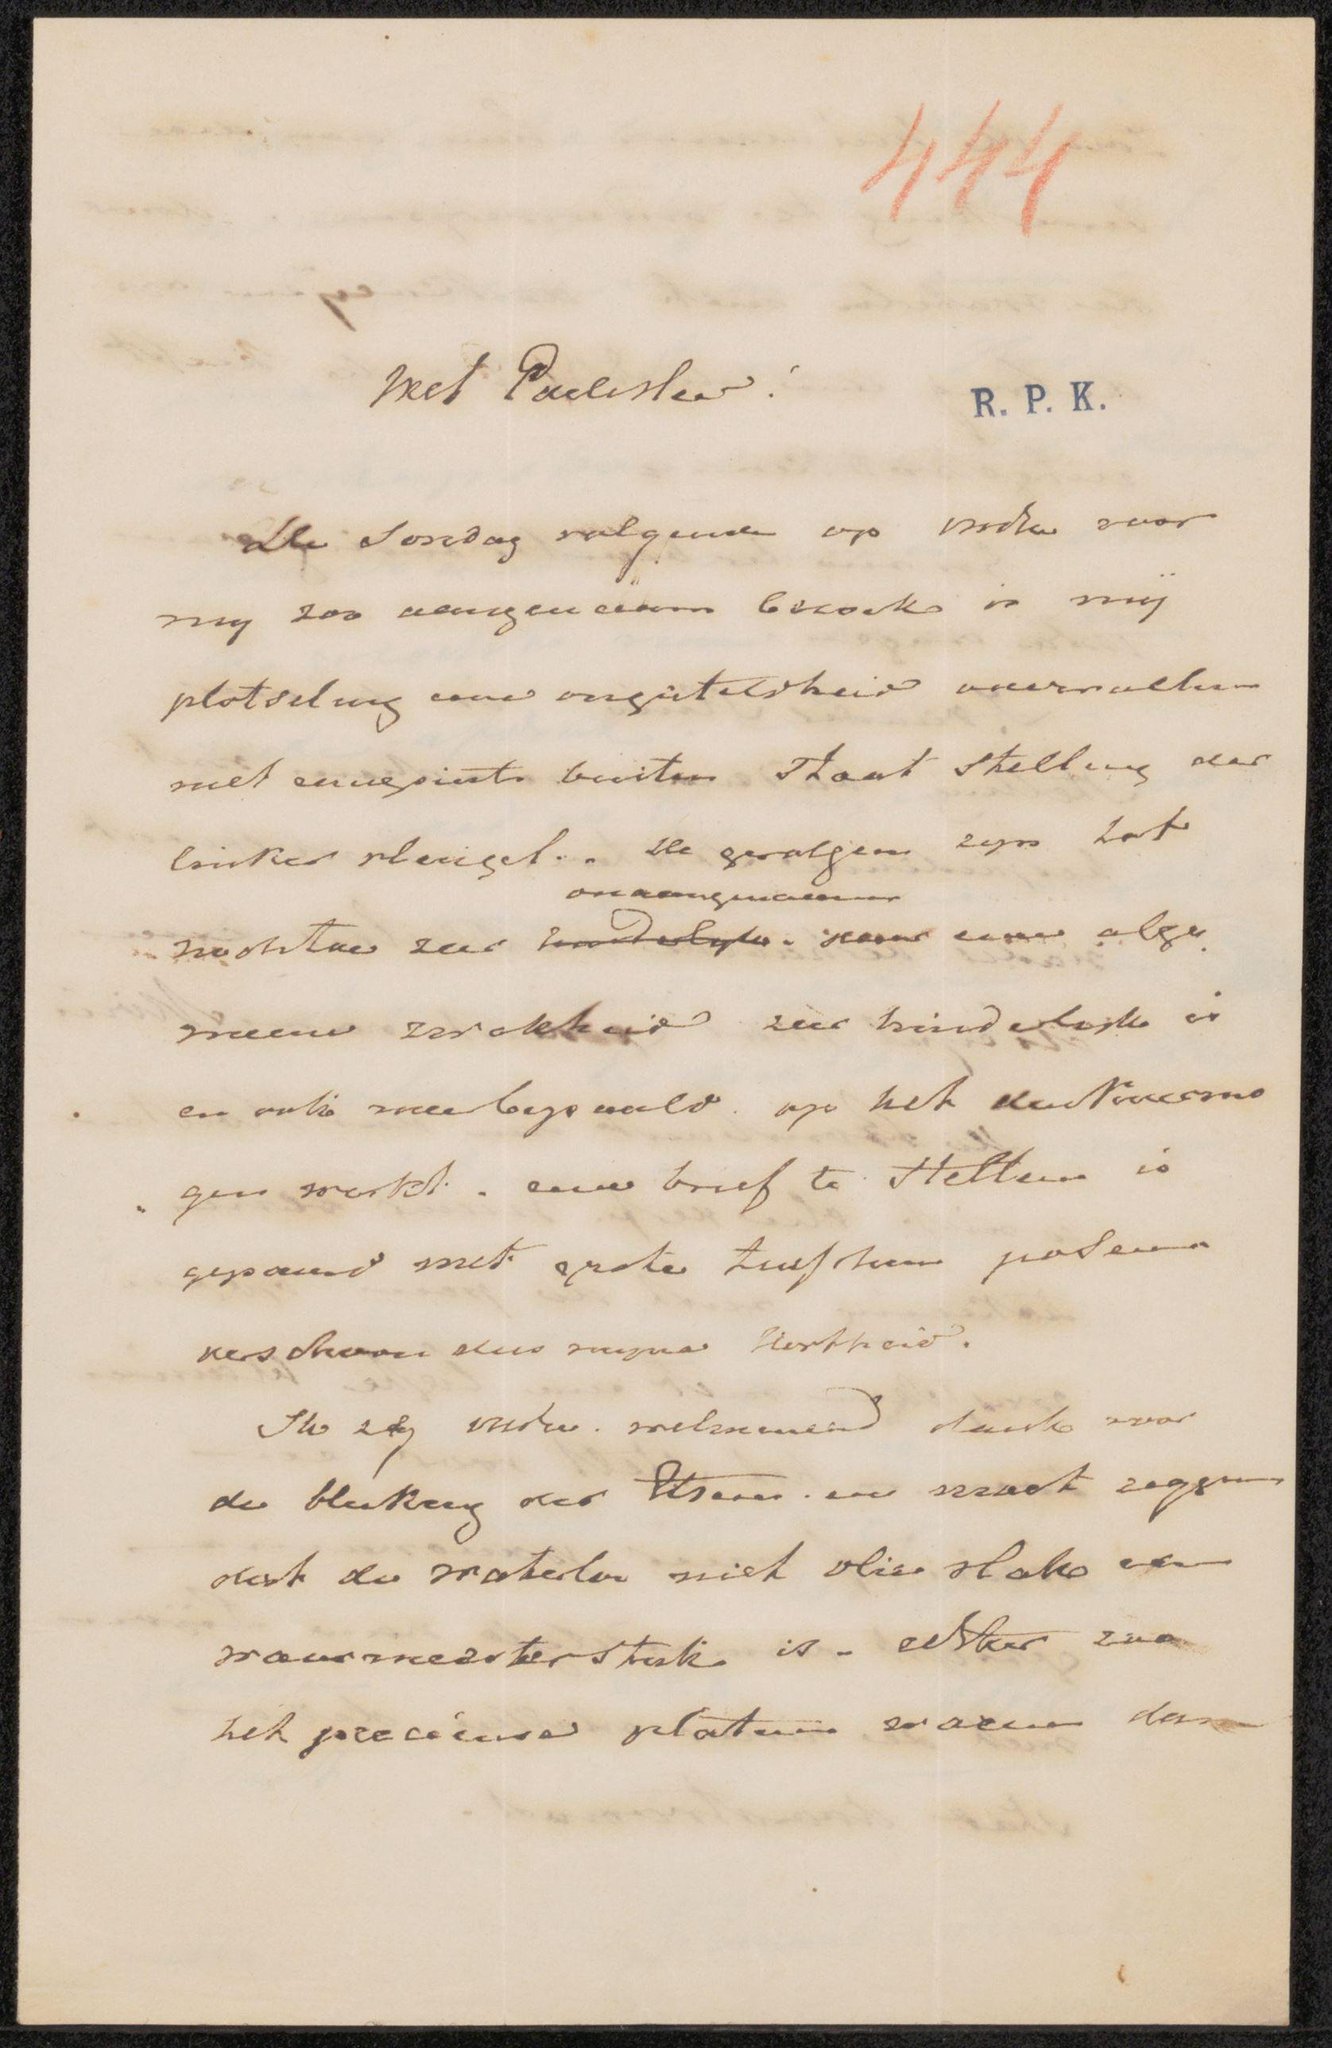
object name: letter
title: Brief aan Christiaan Kramm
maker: gerardus emaus de micault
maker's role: draughtsman, print maker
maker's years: 1798-1863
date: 1861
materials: ink, paper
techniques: pen, writing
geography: gouda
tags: utrecht, christiaan kramm, the graphic arts, money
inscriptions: collector's mark: Lugt 2233